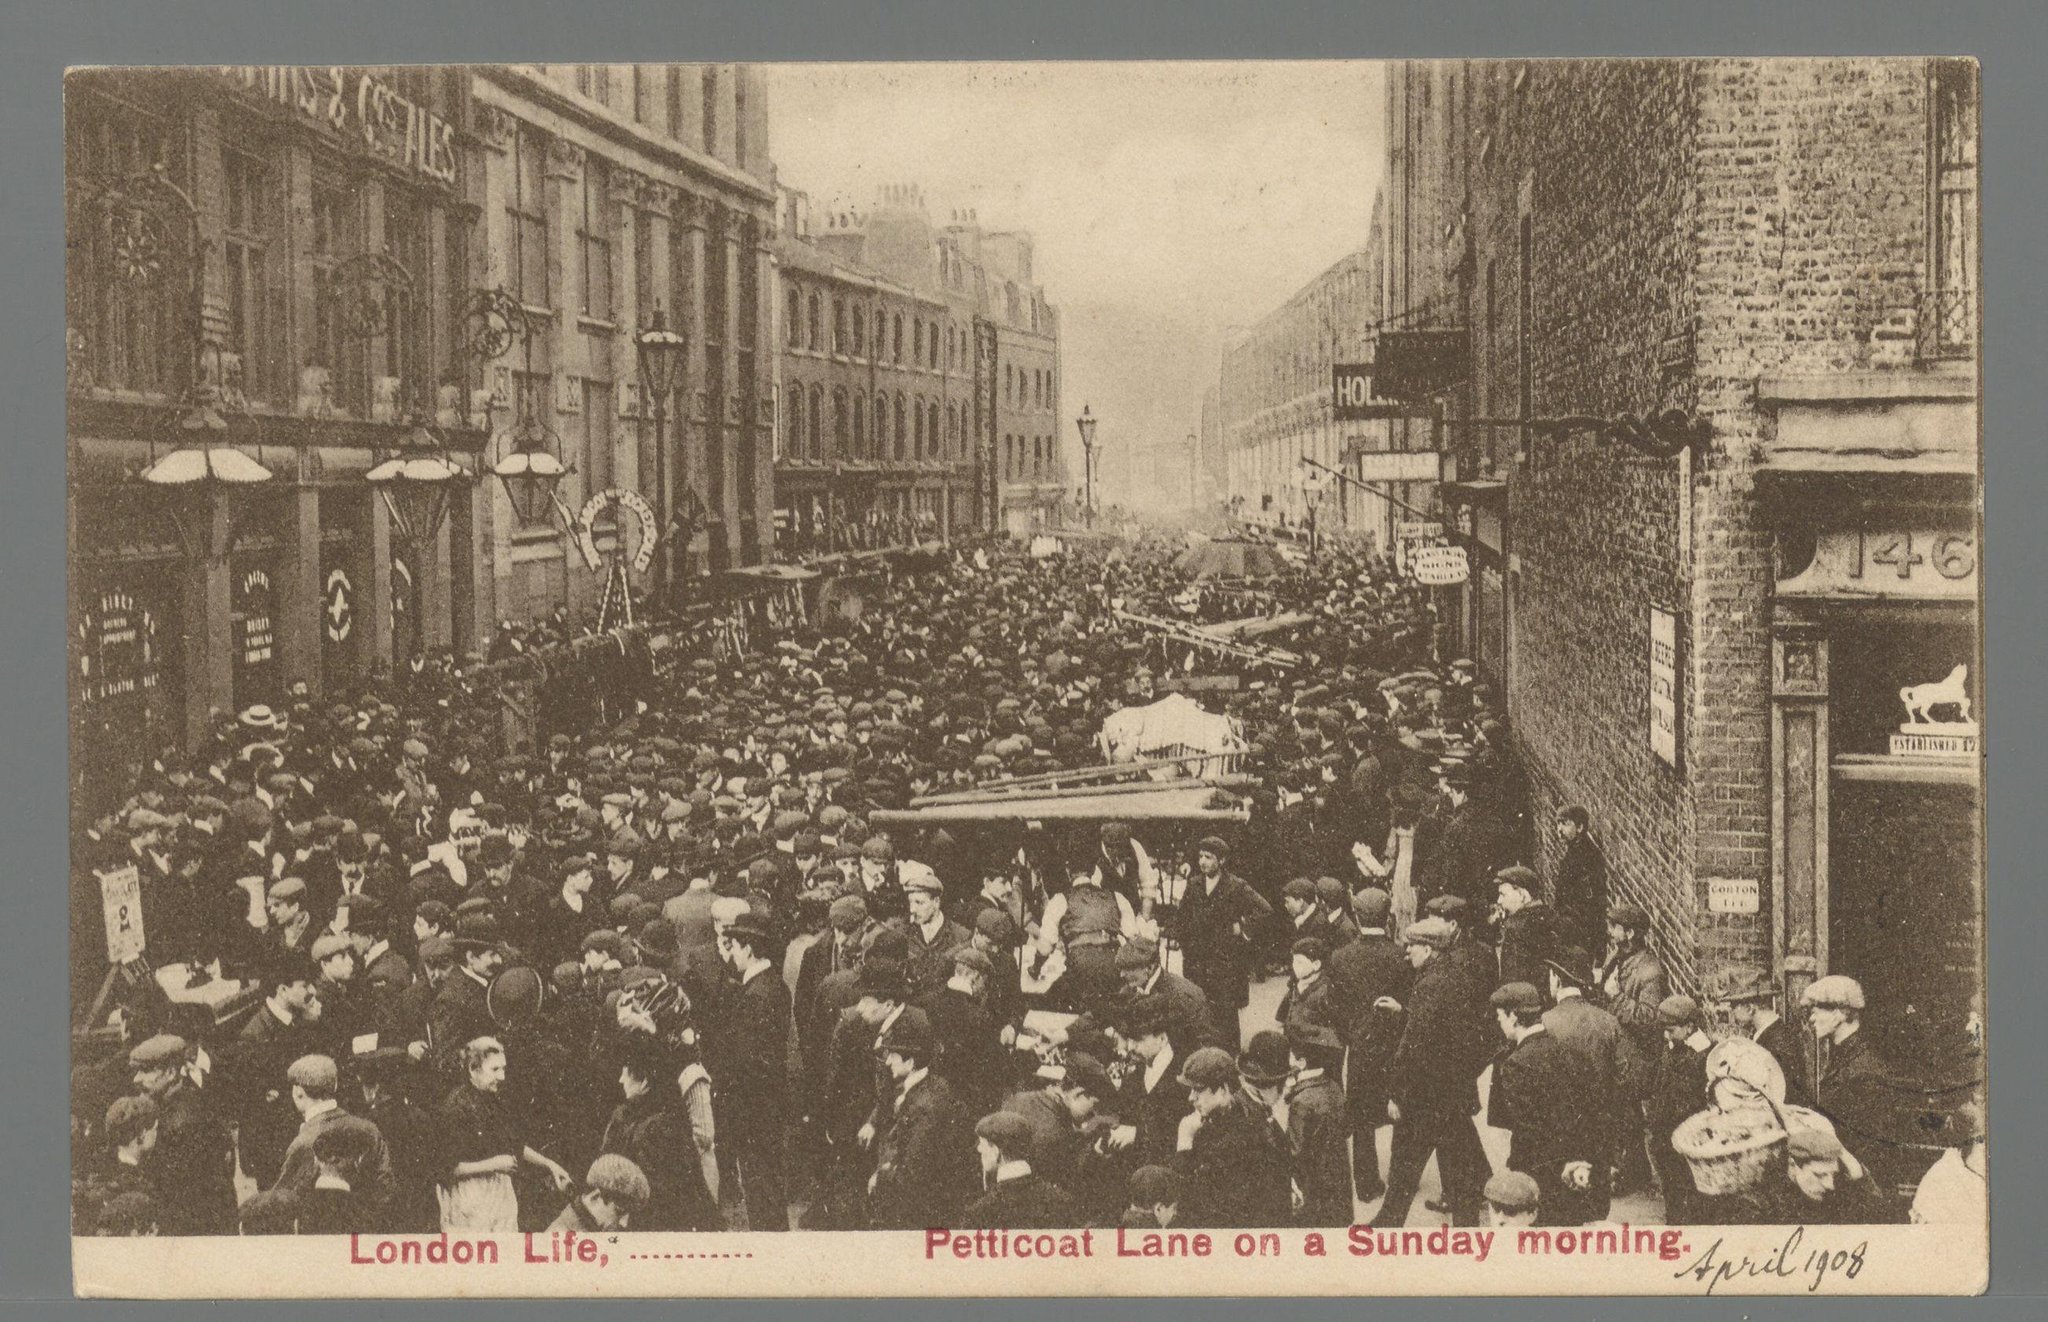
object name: ansichtkaart, prentbriefkaart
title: London Life, Petticoat Lane on a Sunday morning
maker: Anonymous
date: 1902-1908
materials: cardboard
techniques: photograph, writing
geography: london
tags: street, london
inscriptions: postage stamp